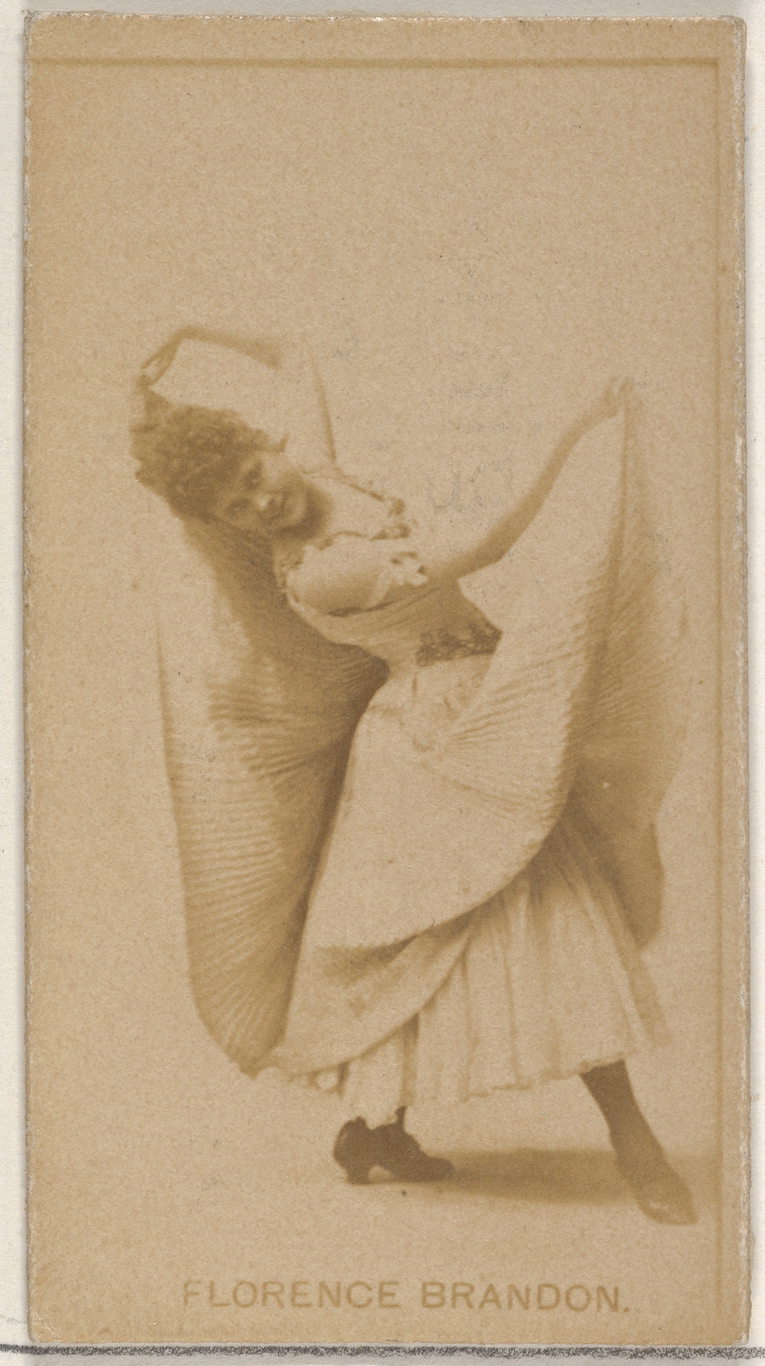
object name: photograph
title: Florence Brandon, from the Actors and Actresses series (N45, Type 8) for Virginia Brights Cigarettes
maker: allen & ginter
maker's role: publisher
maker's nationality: american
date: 1888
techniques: albumen silver print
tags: portraits,women,actresses